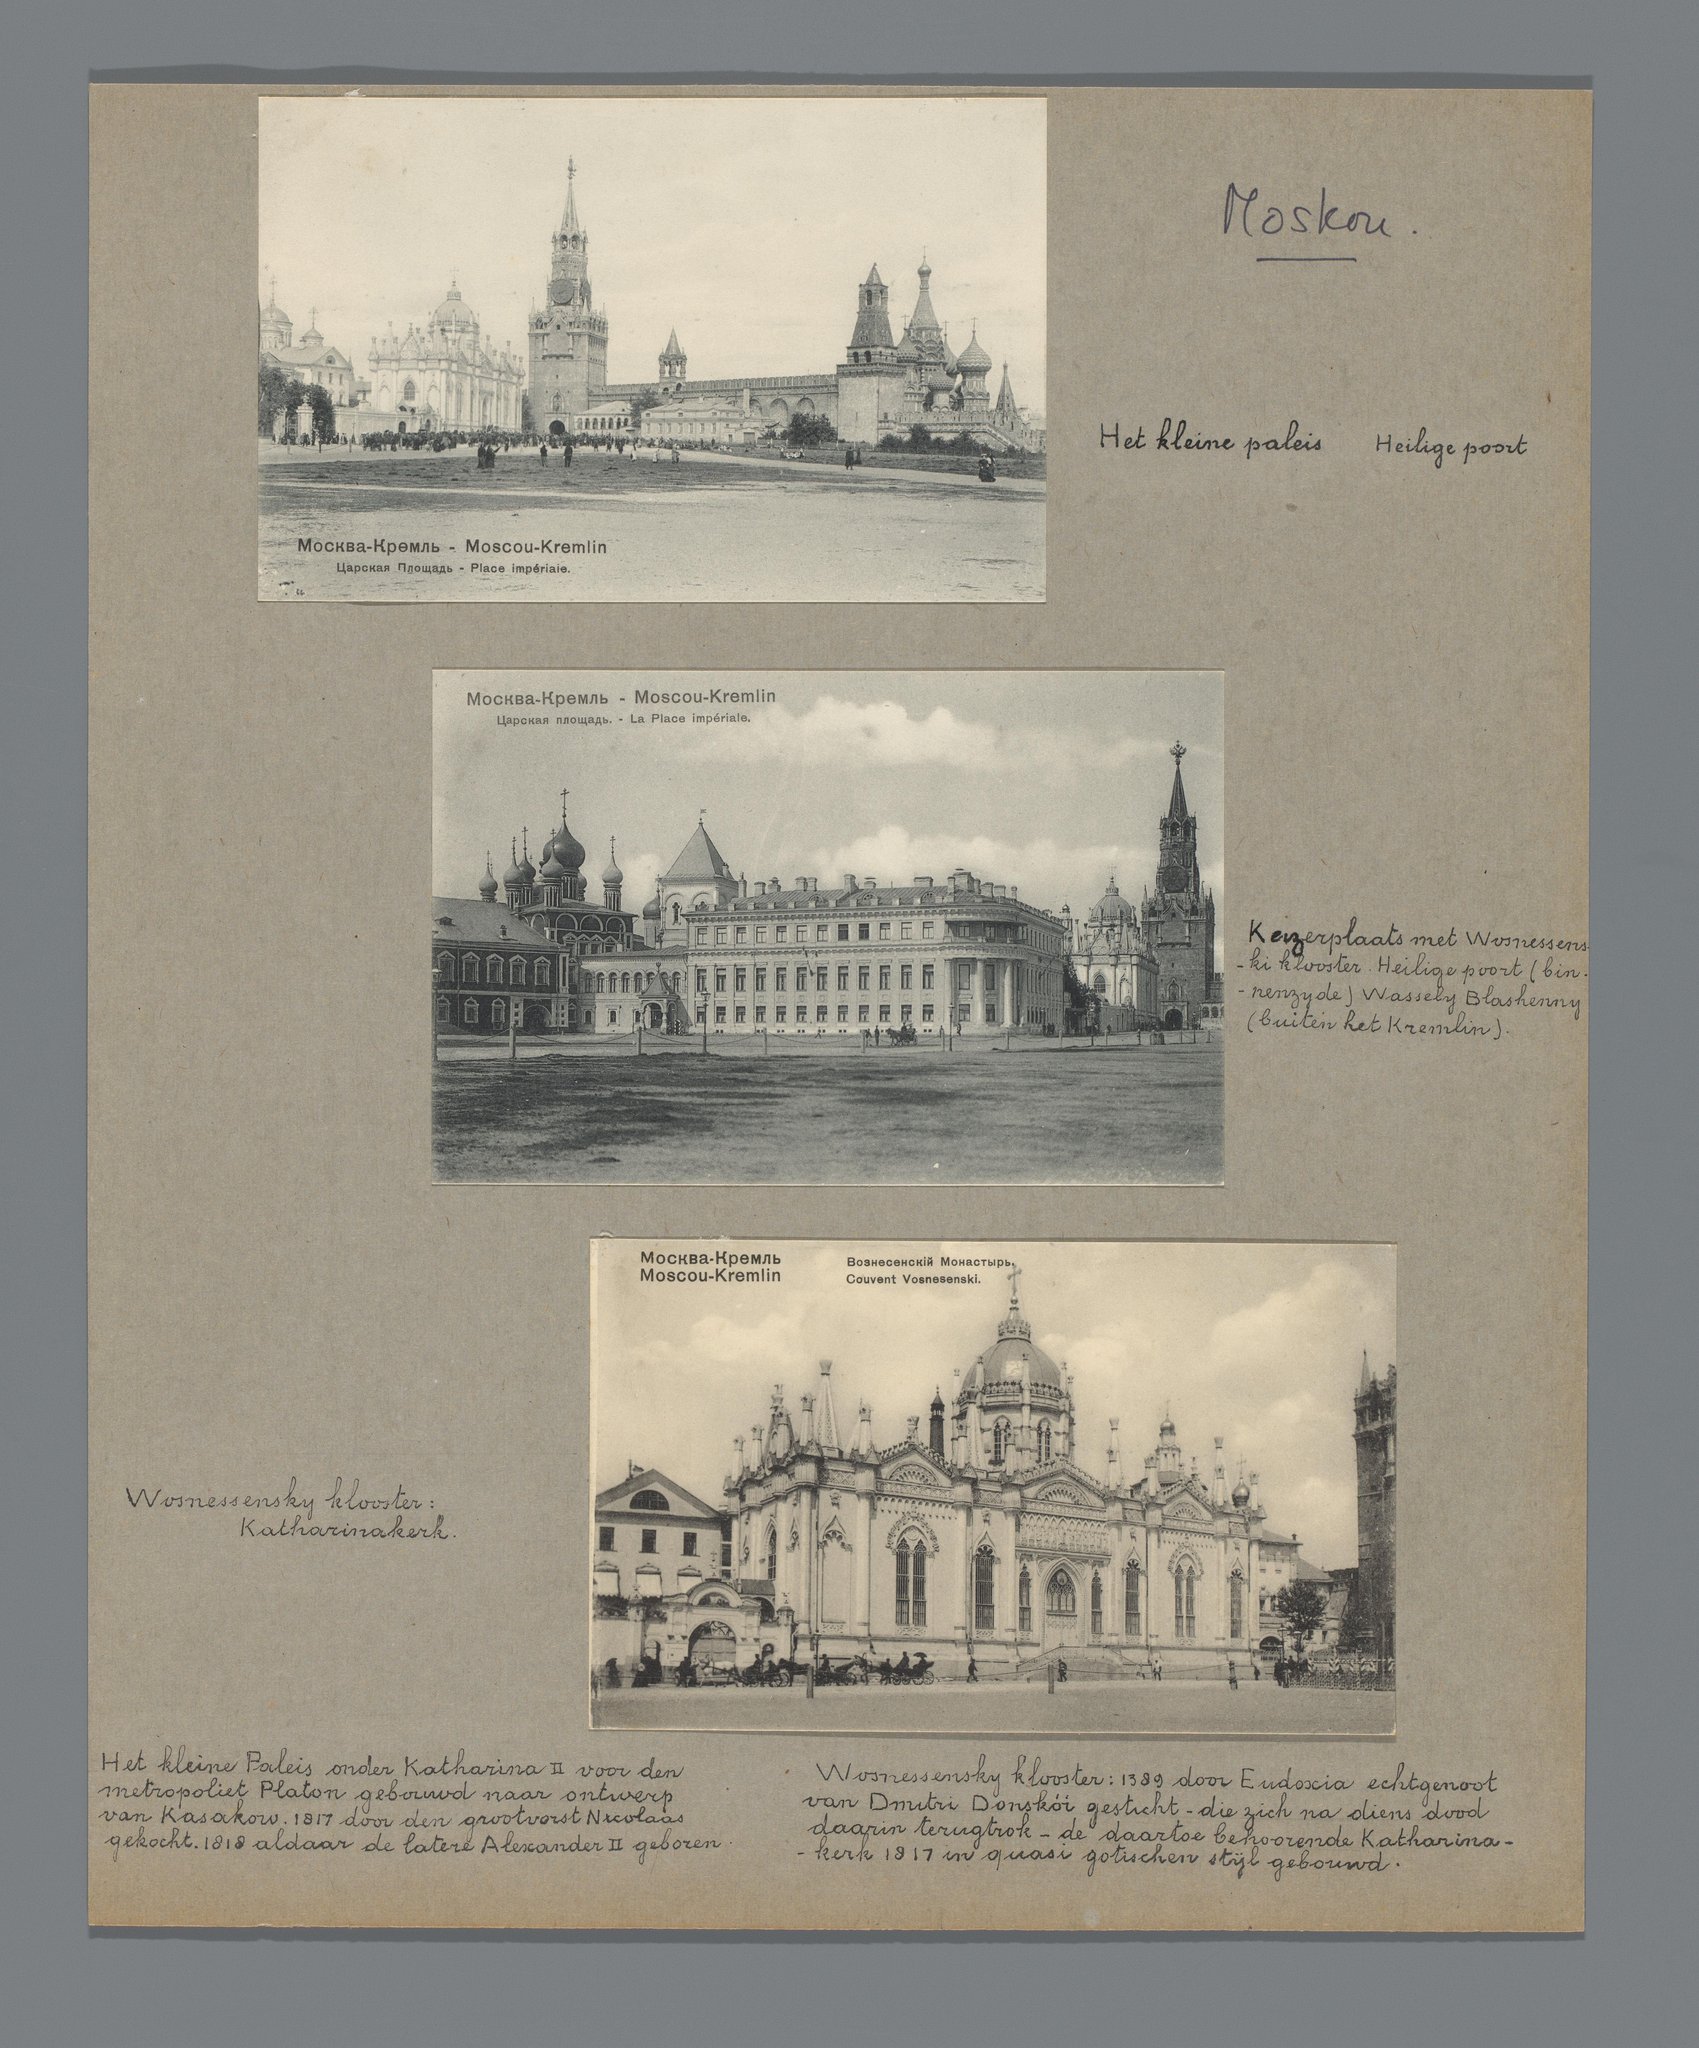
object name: photograph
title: Moskou. Kremlin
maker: Anonymous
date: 1860-1925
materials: photographic support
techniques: photograph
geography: russia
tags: moskou